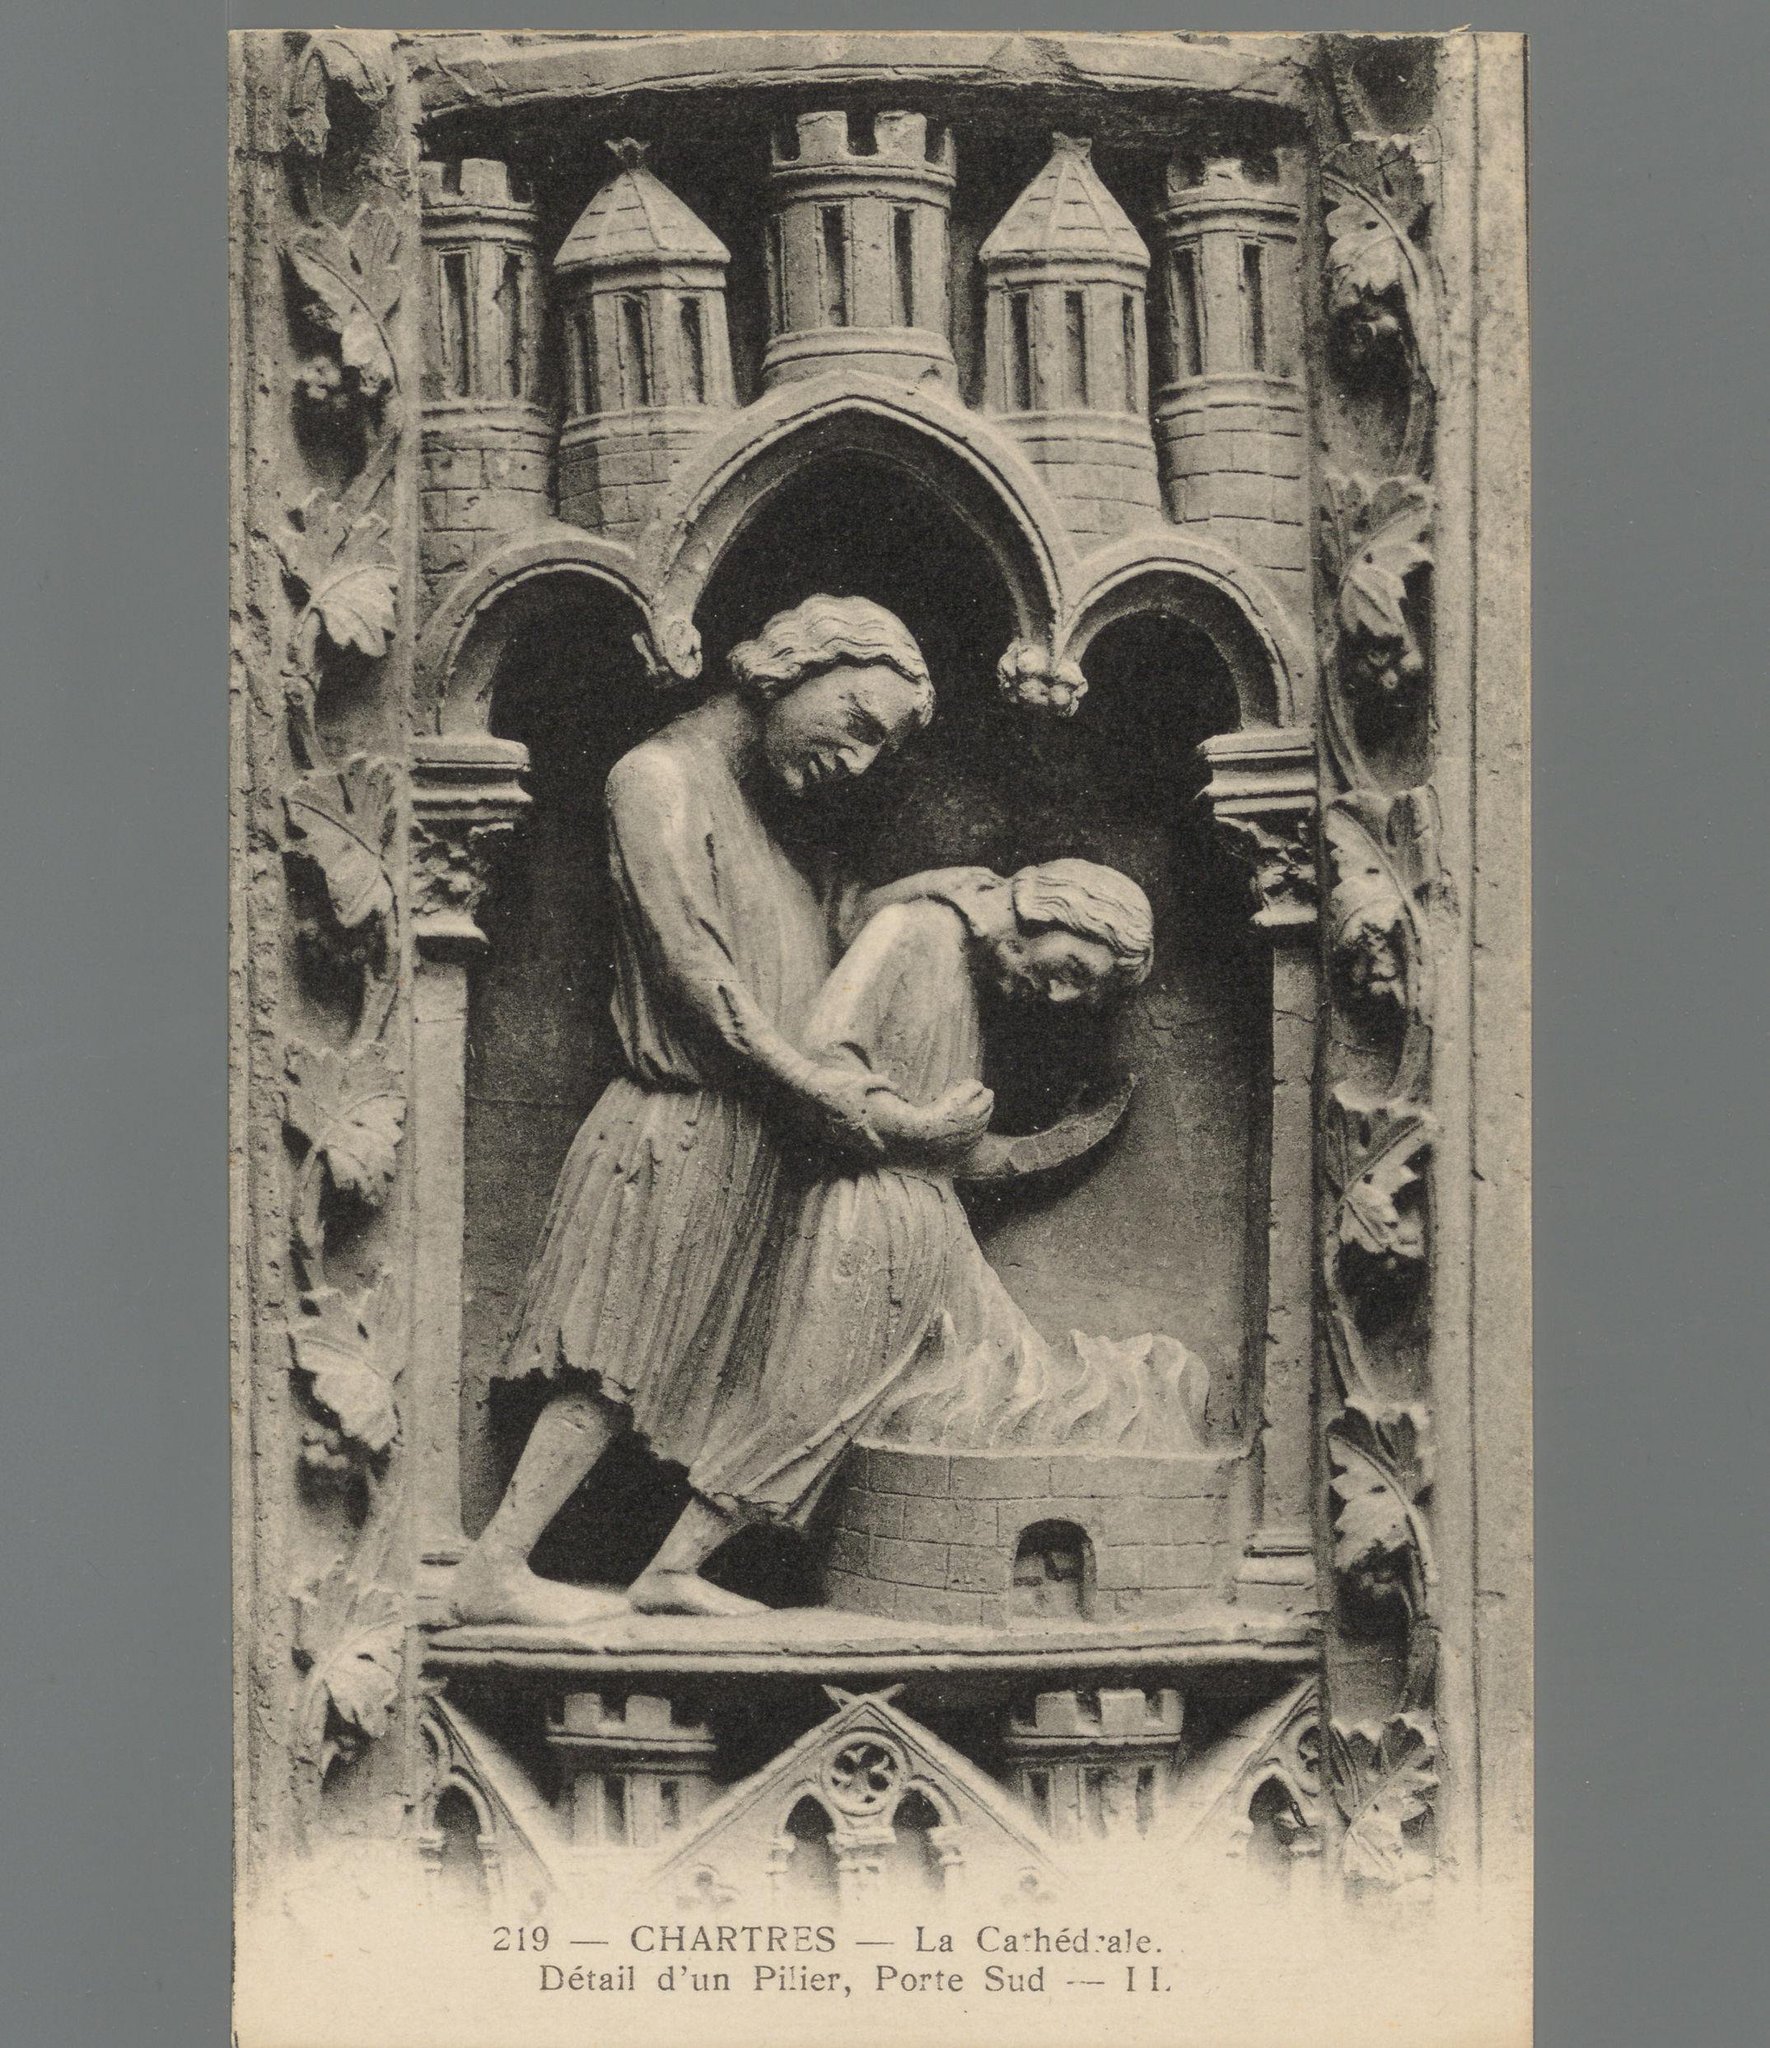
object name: photomechanical print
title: Chartres - La Cathédrale. Détail d'un Pilier, Porte Sud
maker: Anonymous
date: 1903-1932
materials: cardboard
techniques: photograph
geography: chartres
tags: column, pillar ~ architecture, church (exterior)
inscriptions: collector's mark: ‘AFE v S’